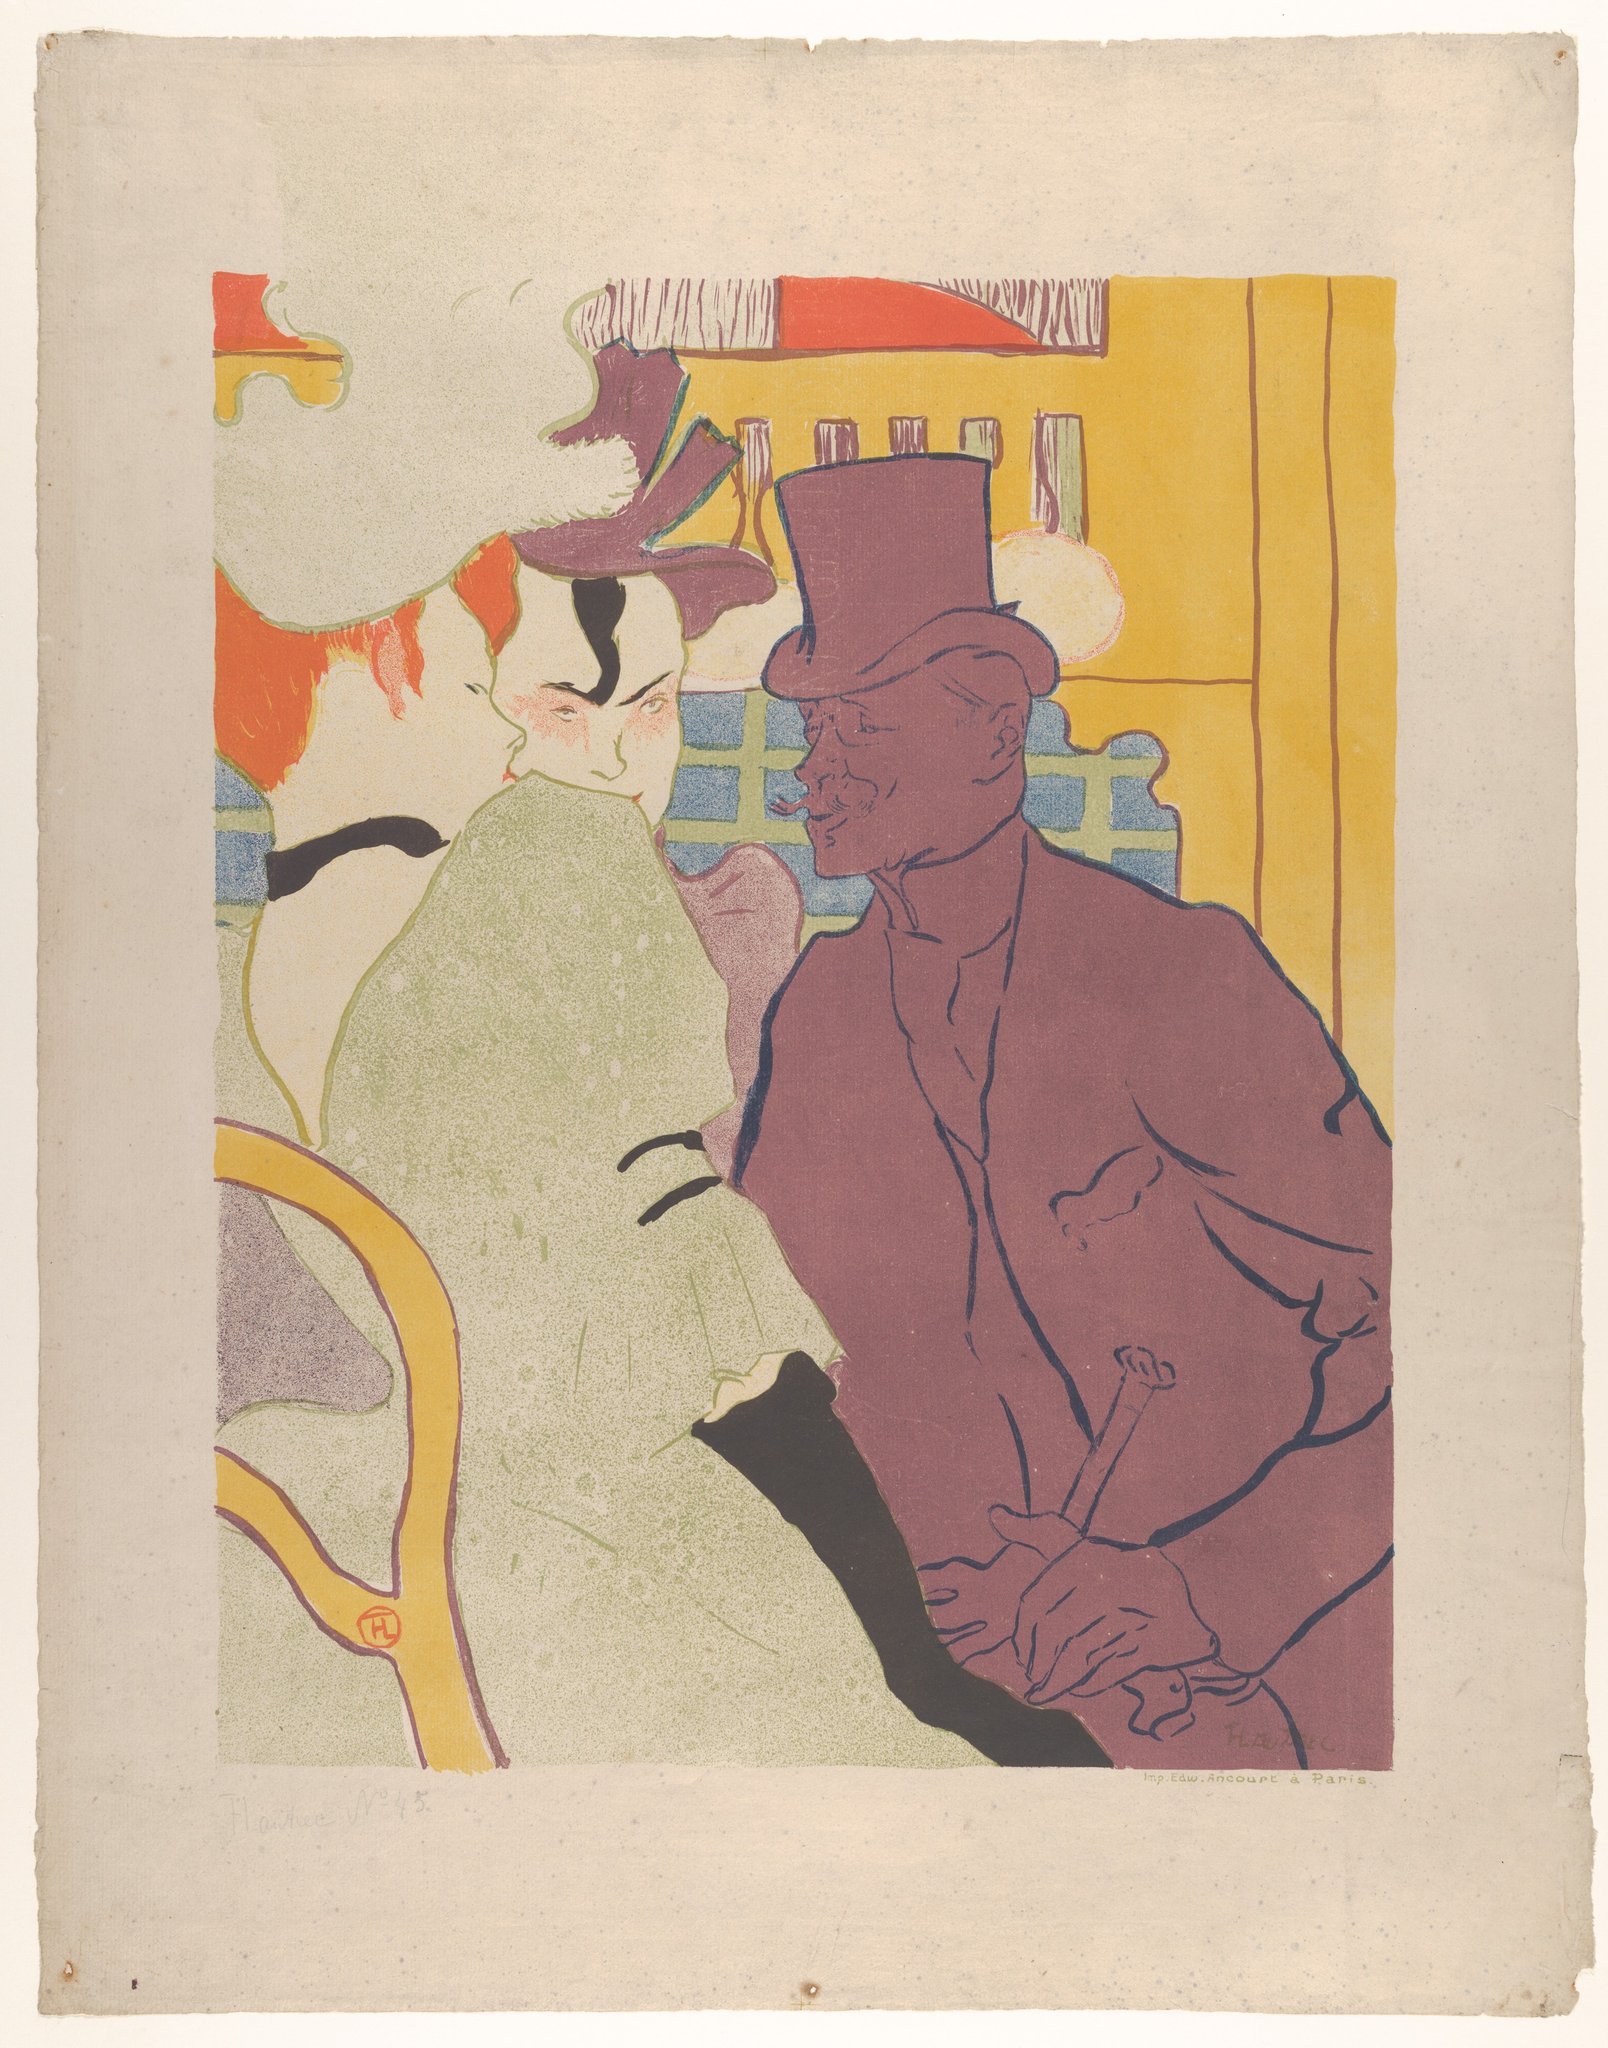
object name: print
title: The Englishman at the Moulin Rouge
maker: henri de toulouse-lautrec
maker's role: artist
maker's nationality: french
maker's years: 1864-1901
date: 1892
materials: paper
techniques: lithograph, printing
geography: france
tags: men,women